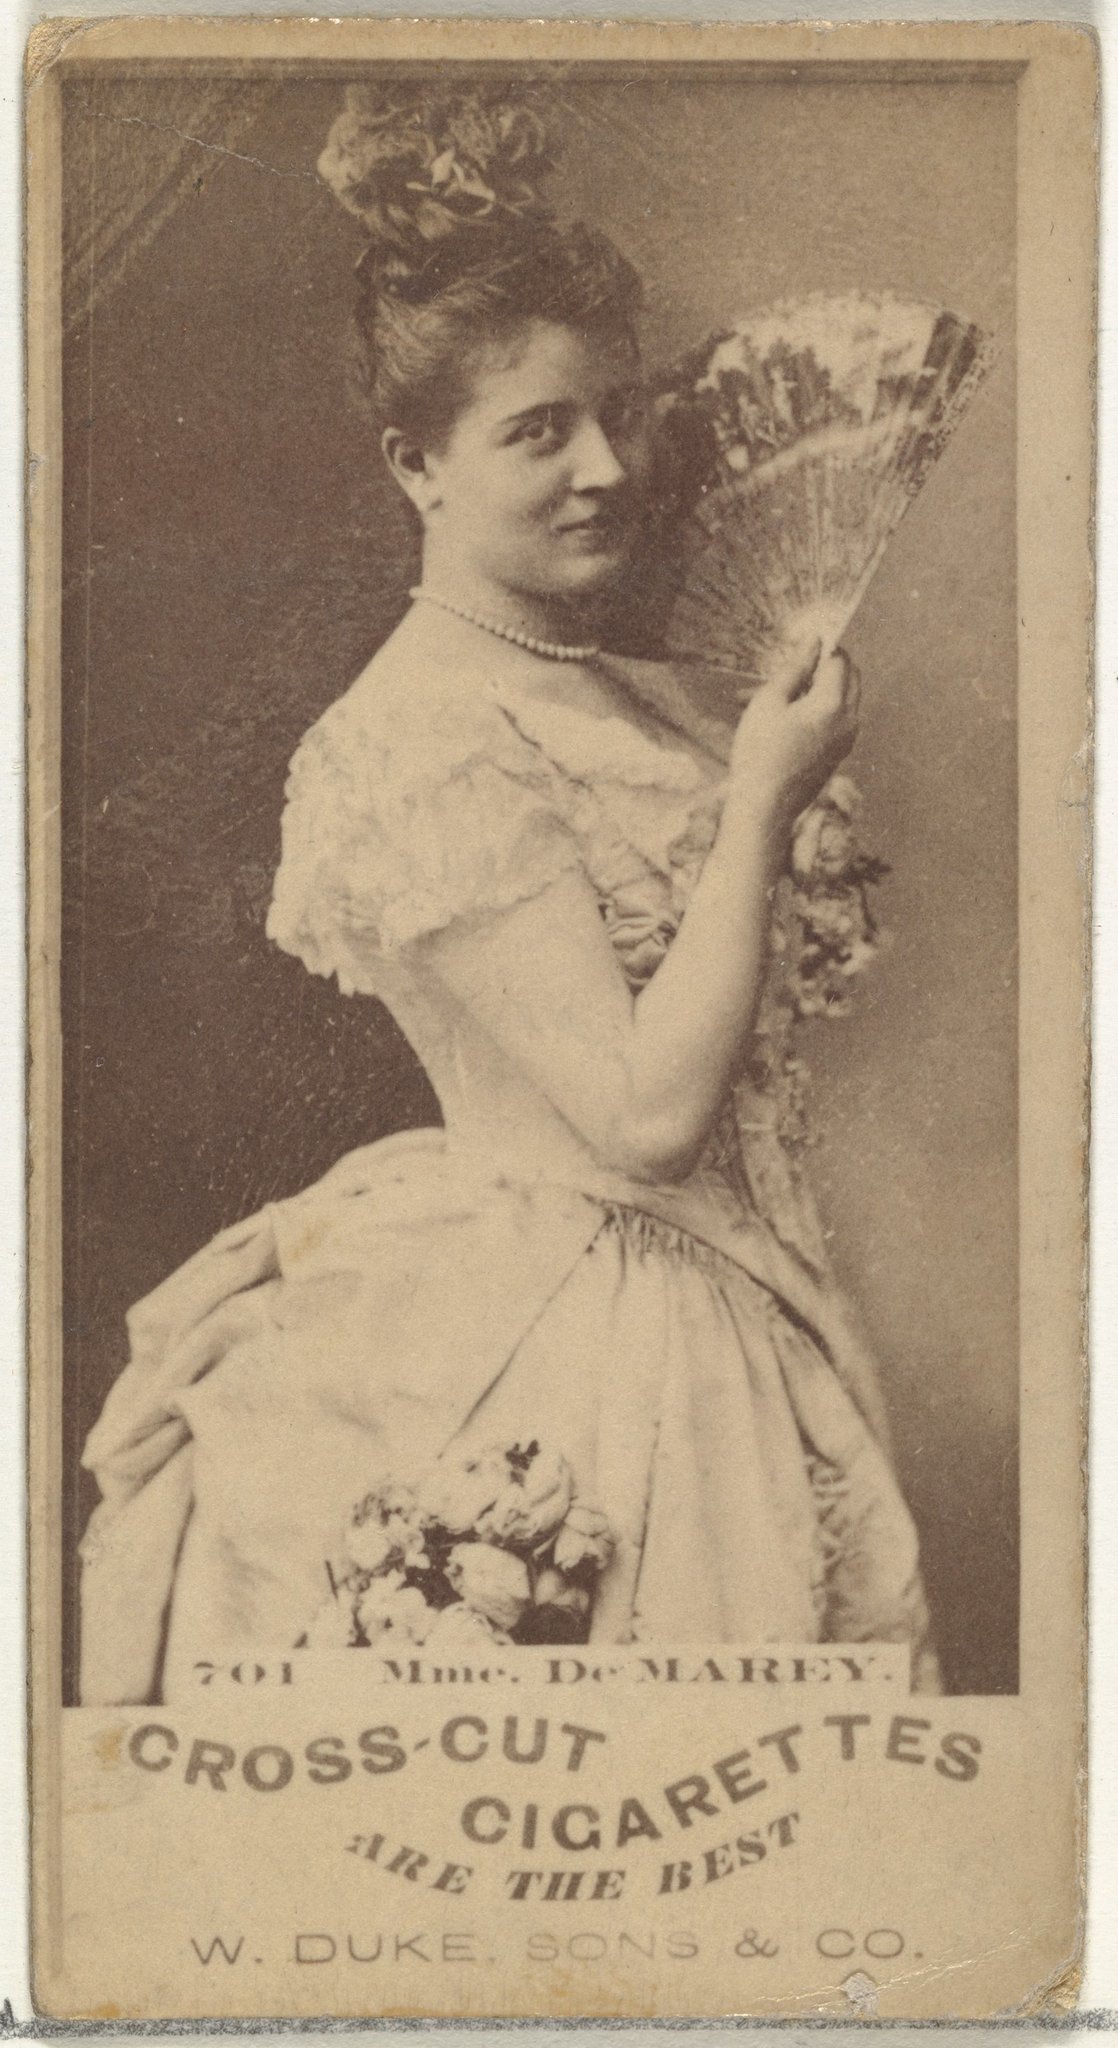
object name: photograph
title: Card Number 701, Mme. De Marey, from the Actors and Actresses series (N145-3) issued by Duke Sons & Co. to promote Cross Cut Cigarettes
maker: w. duke, sons & co.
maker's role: publisher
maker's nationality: american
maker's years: 1870-1920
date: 1880-1889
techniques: albumen silver print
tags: fans,portraits,women,actresses